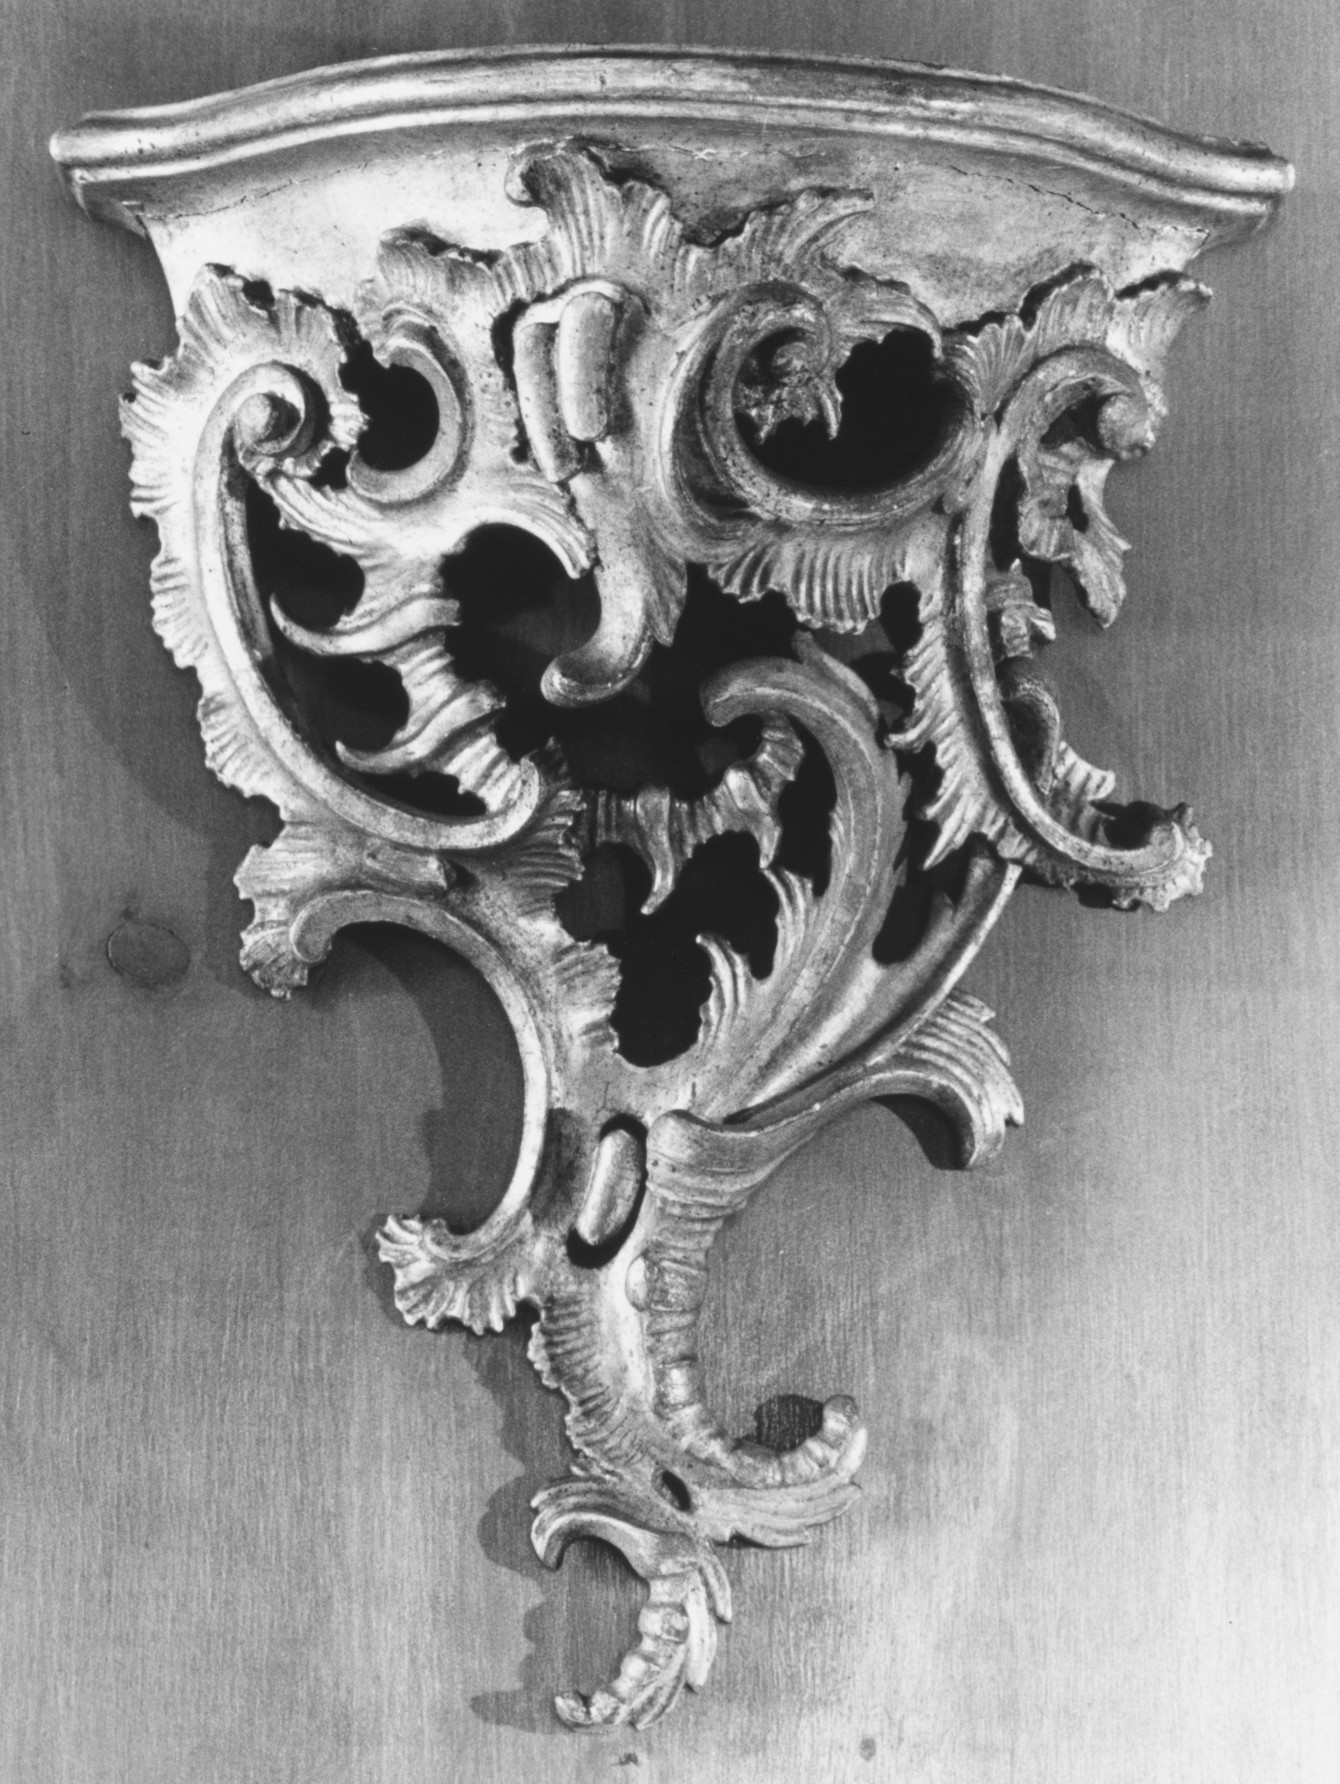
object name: wall bracket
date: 1750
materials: wood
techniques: carving, gilding